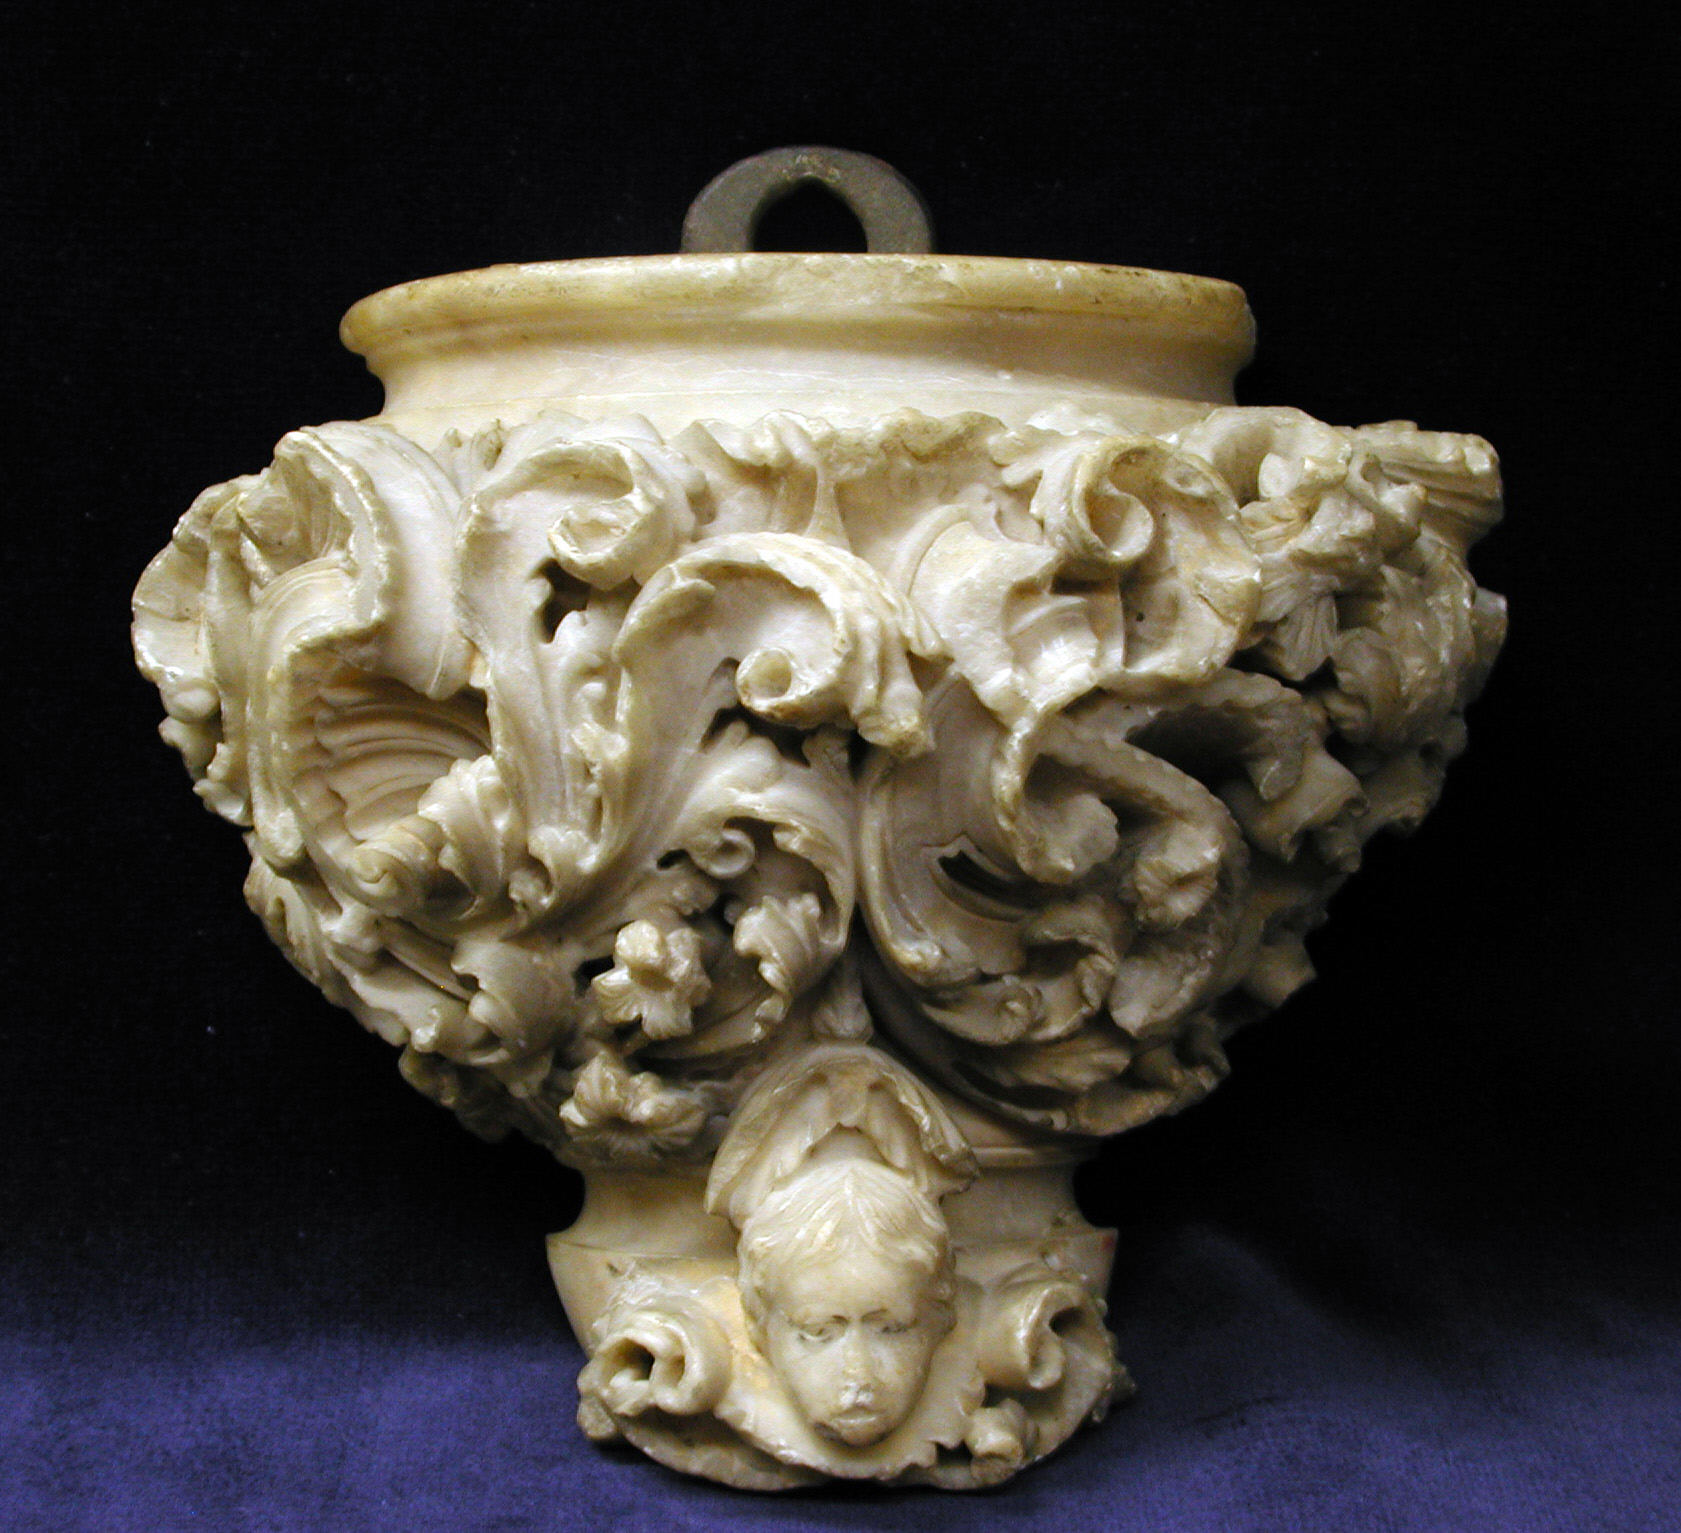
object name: bracket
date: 1534-1566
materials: alabaster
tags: heads